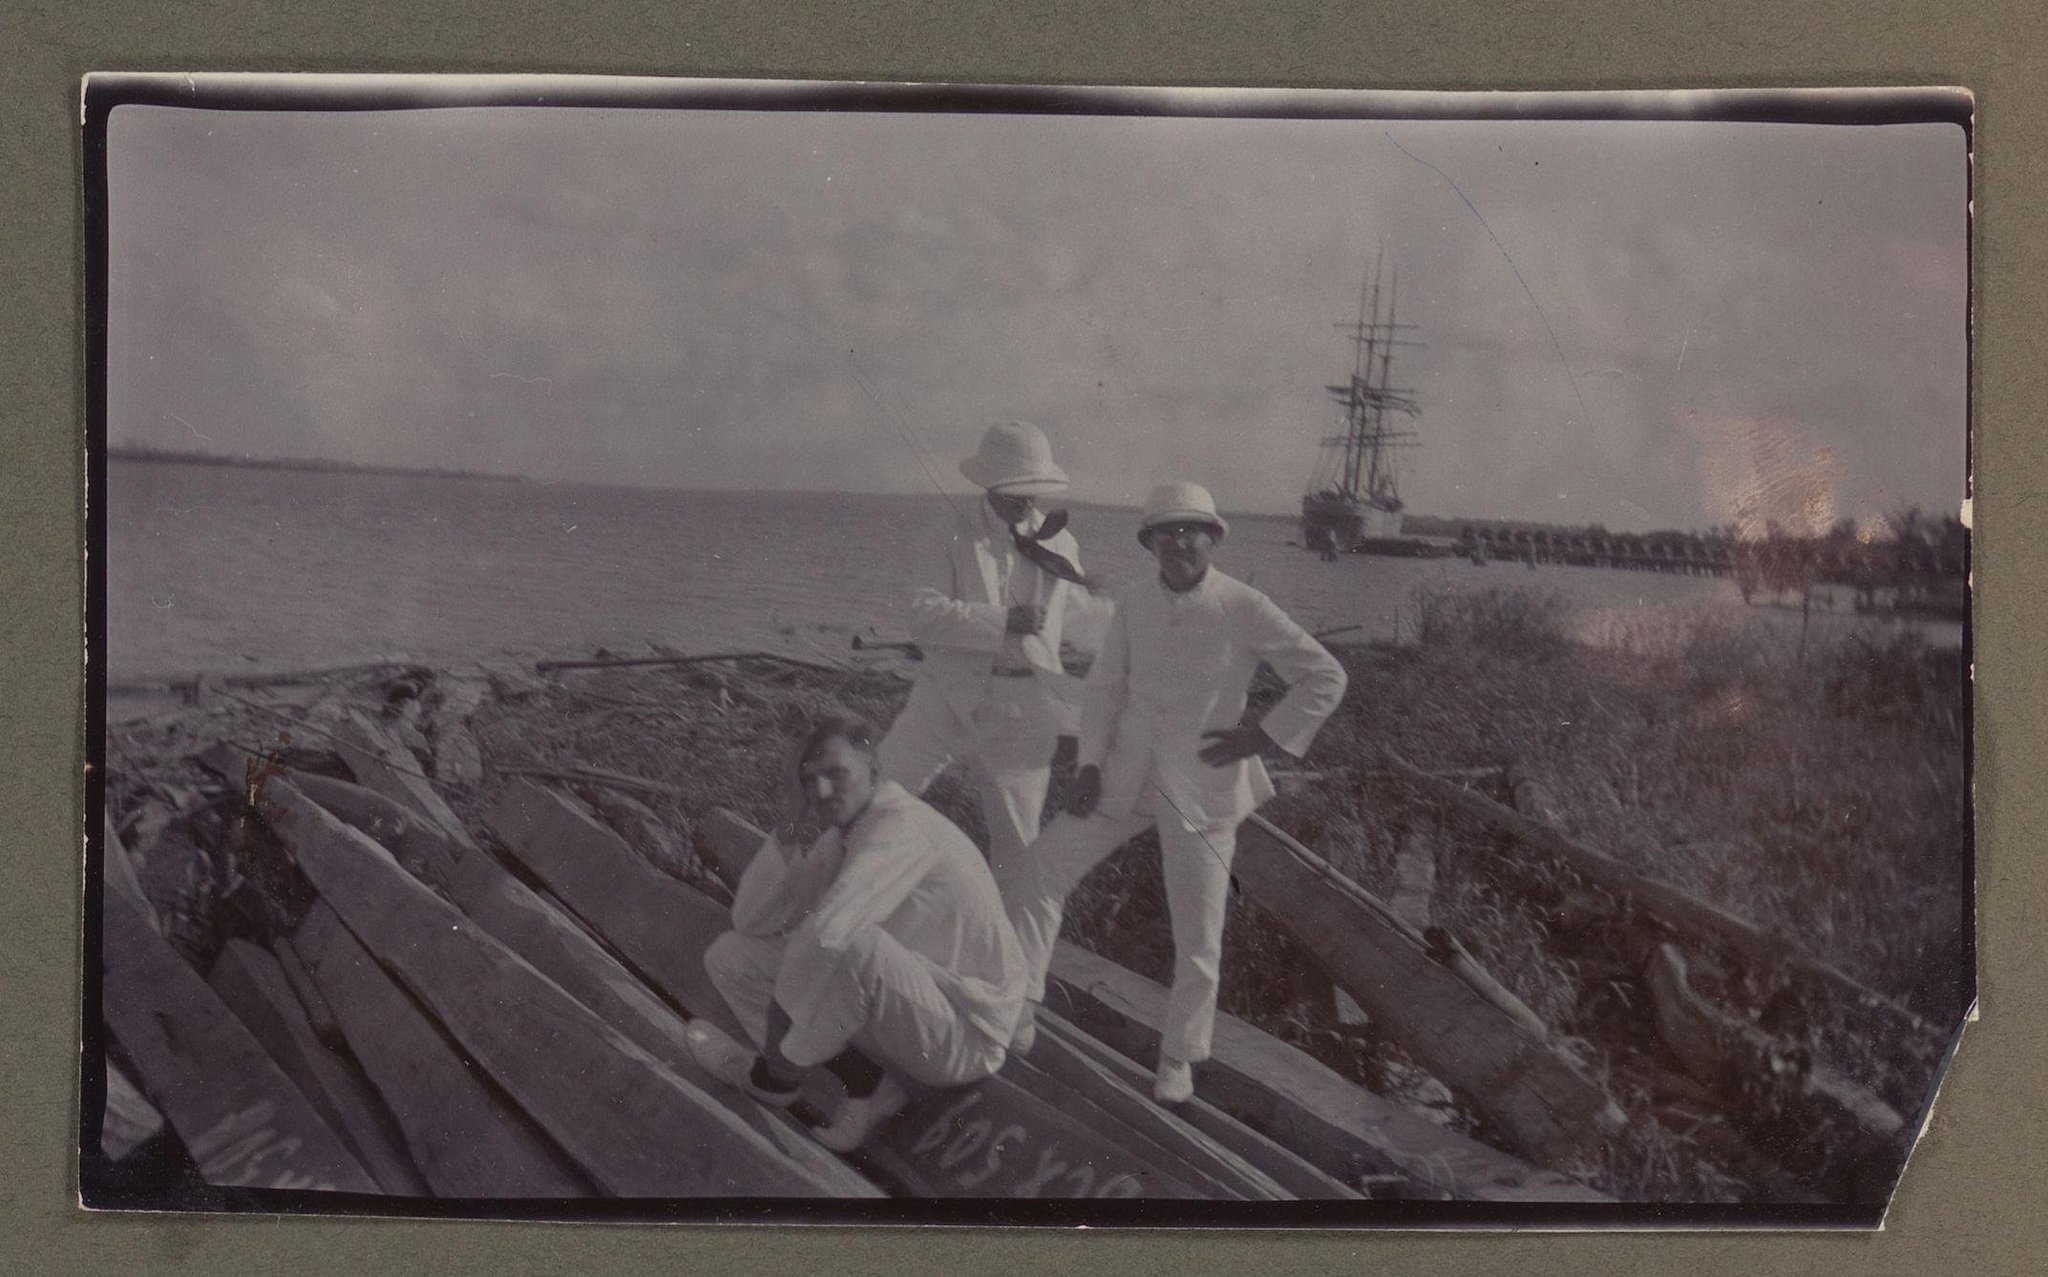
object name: photograph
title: Aan de Waterkant van Paramaribo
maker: Anonymous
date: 1925-1927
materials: photographic support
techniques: photography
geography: suriname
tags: jetten, familie, moengo, waterkant, paramaribo (stad)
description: Drie mannen (waaronder R.A. Jetten) aan de Waterkant van Paramaribo. Foto op een bladzijde van een los albumblad. Onderdeel van het ensemble met foto's van de familie van ingenieur Jetten in de mijnbouwstad Moengo in Suriname.